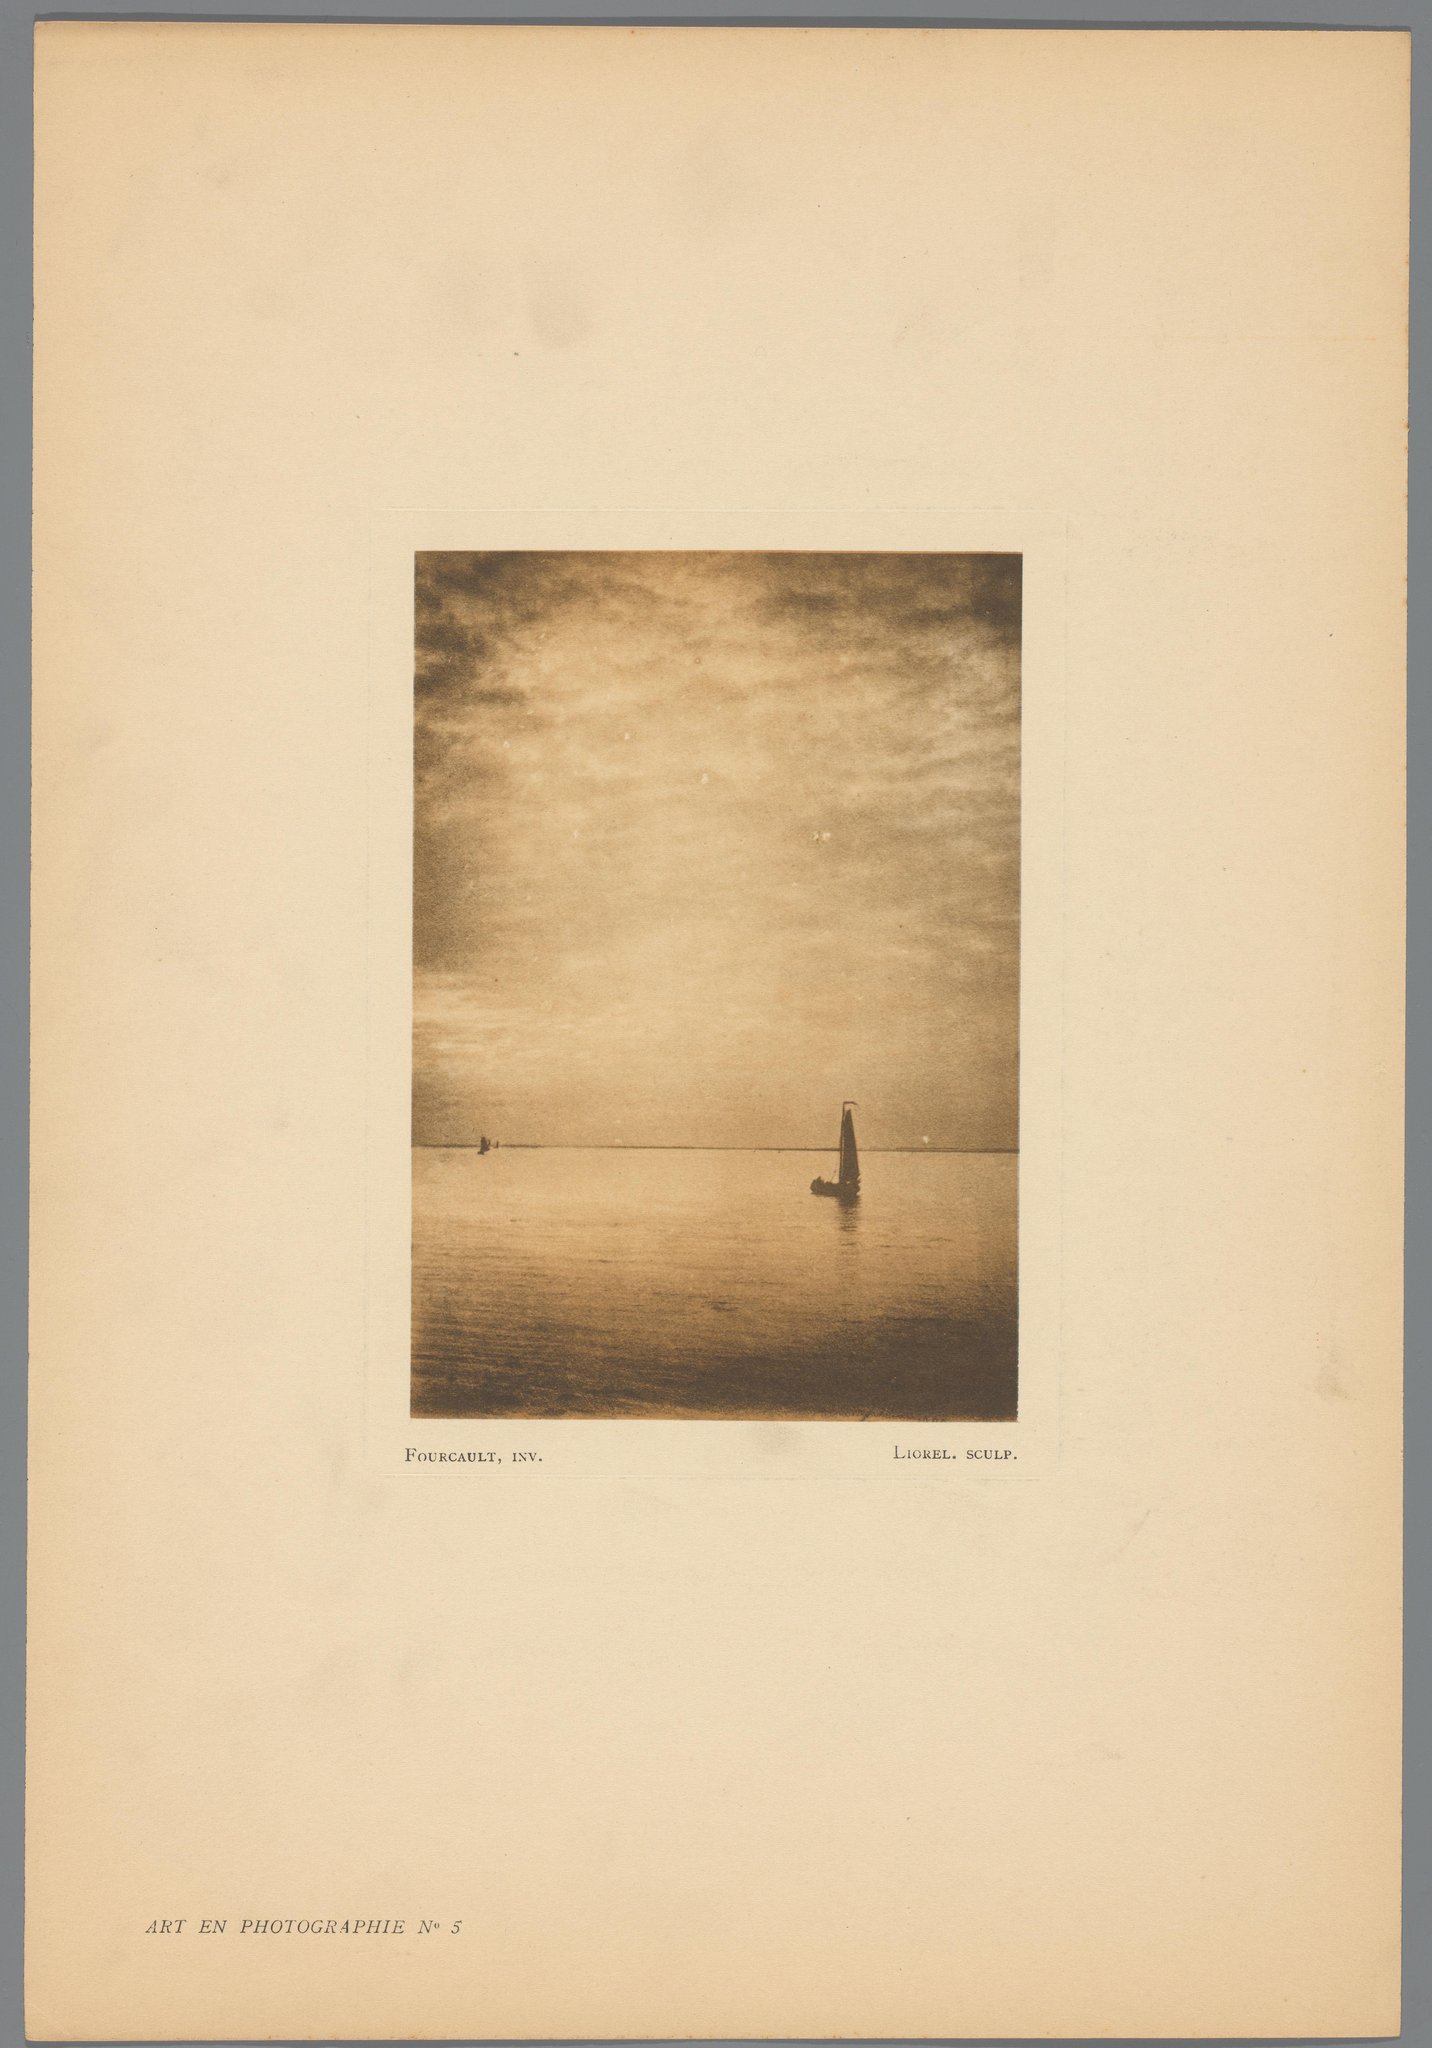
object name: photomechanical print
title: Zeelandschap met zeilschip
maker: emile fourcault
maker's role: fotograaf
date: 1896-1901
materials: paper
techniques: photograph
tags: sailing-ship, sailing-boat, sea (seascape)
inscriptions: inscription: ‘ART EN PHOTOGRAPHIE No 5’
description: Deze prent maakt deel uit van een omslag met 54 prenten op 52 bladen.